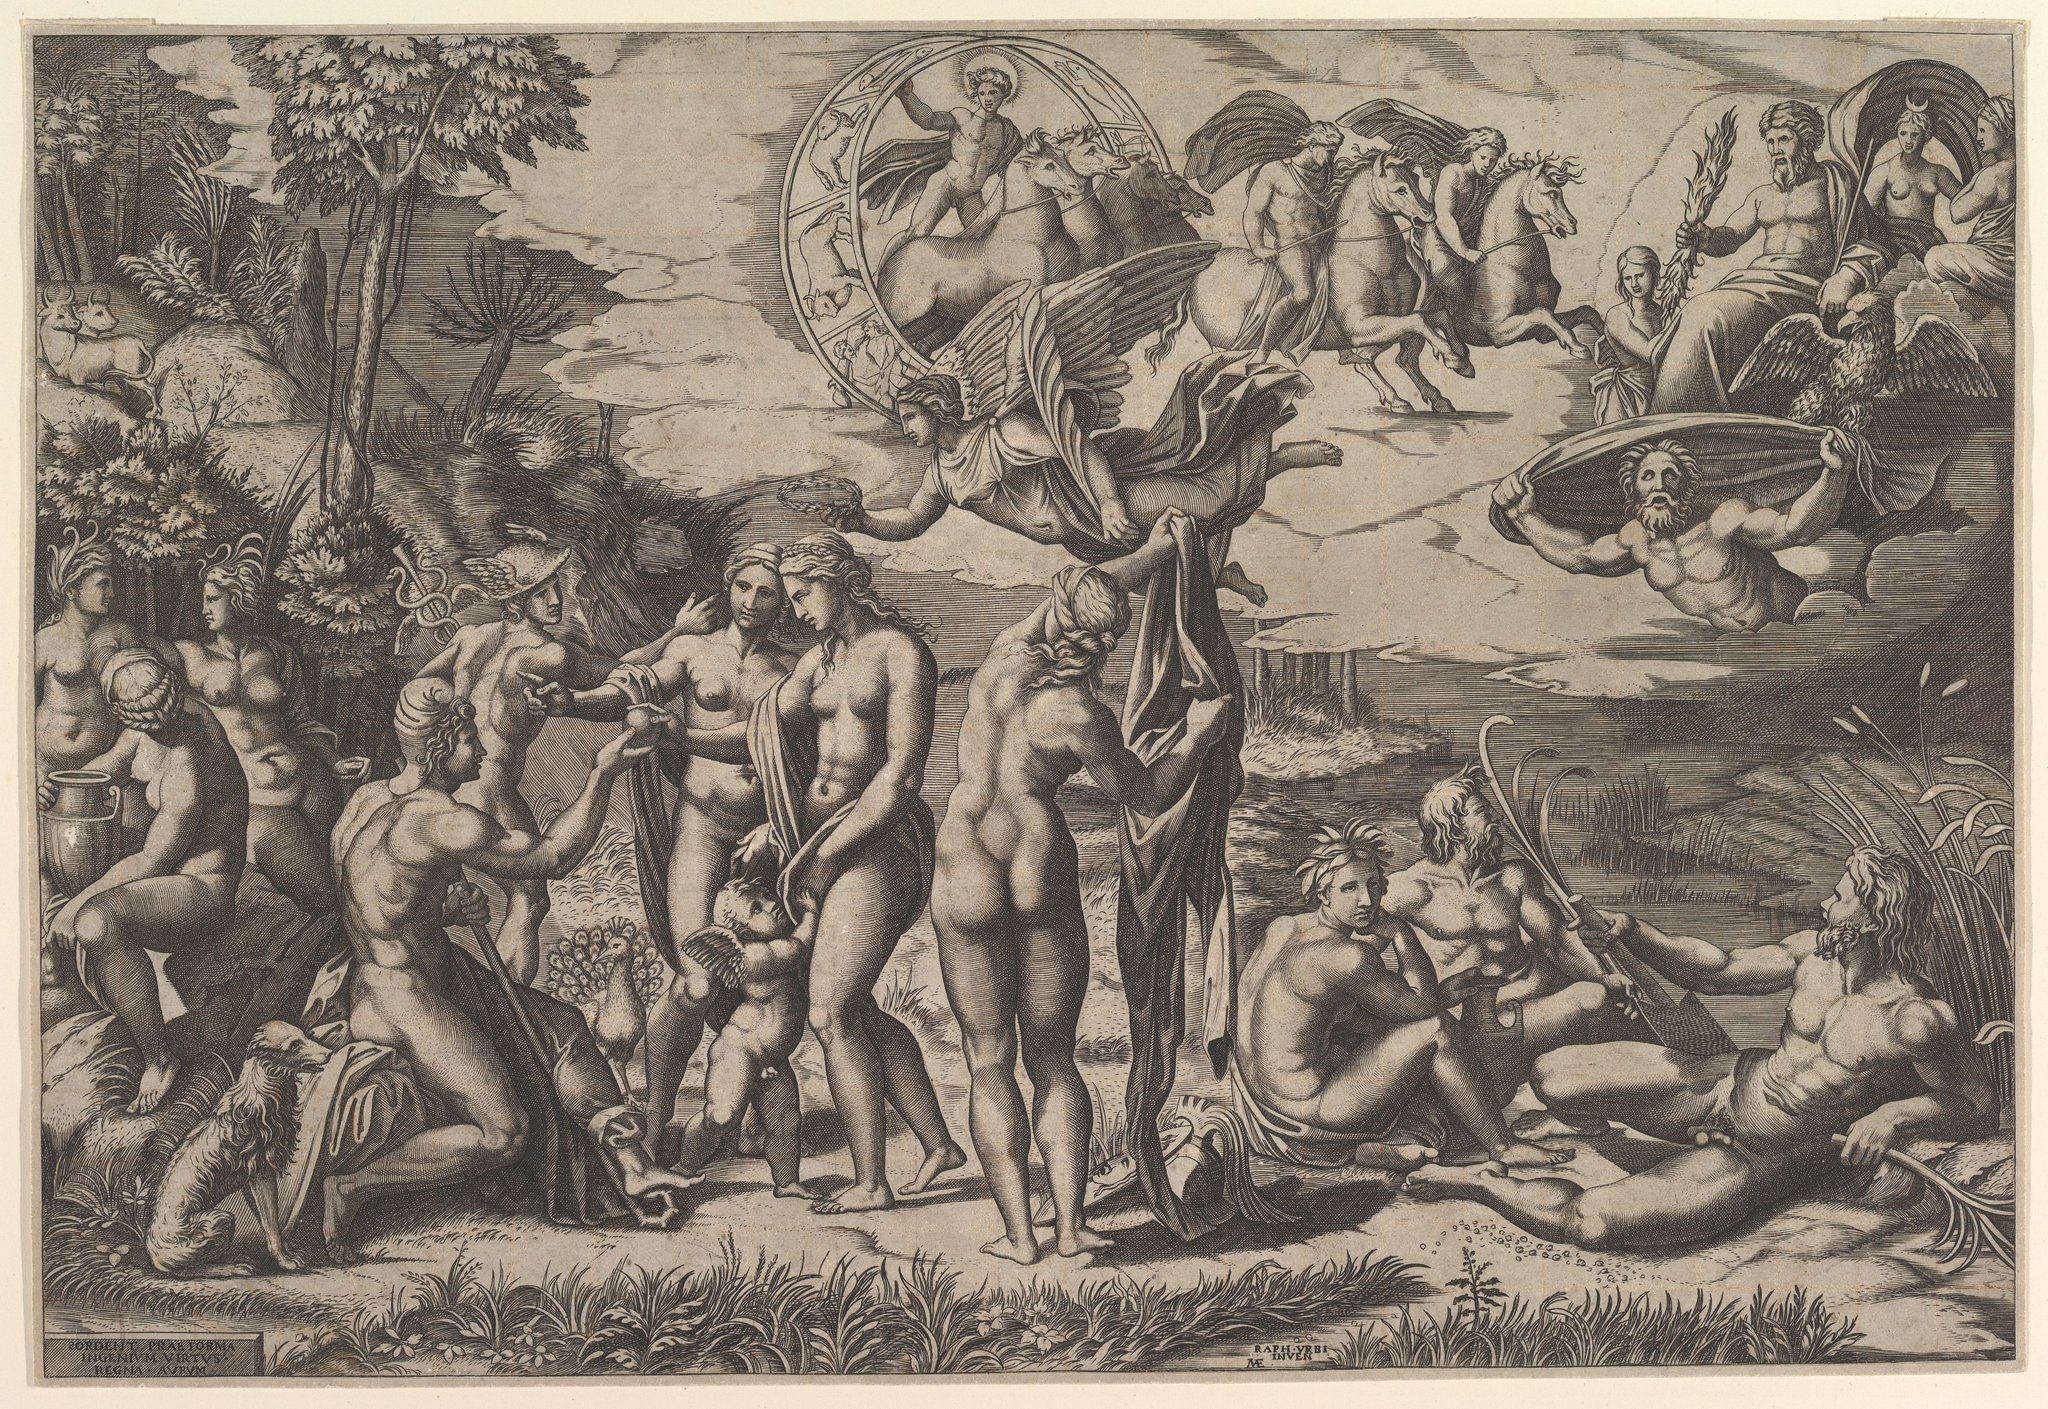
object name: print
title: The Judgment of Paris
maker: marco dente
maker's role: artist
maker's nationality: italian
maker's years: 1515-1527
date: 1515-1527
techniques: engraving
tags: male nudes,female nudes,horses